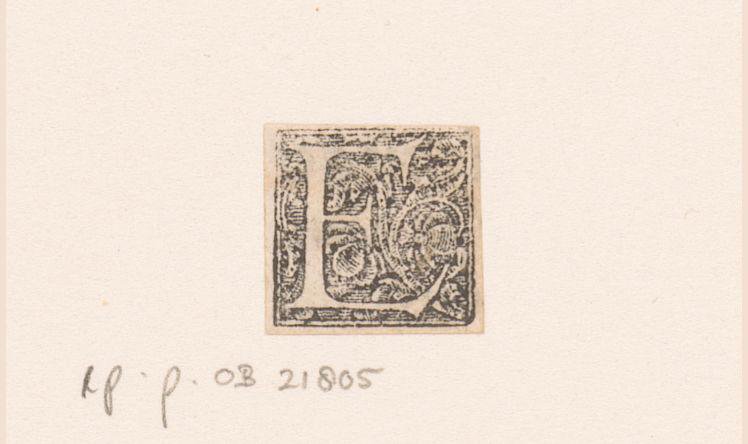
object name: print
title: Letter E: rankenornament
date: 1556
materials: paper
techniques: letterpress printing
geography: zurich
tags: initial, ornament derived from plant forms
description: Prent afkomstig uit: Bibel, die gantze, das ist alle Bücher alts und news Testaments (...). Zürich: Johann Froschauer, 1556.